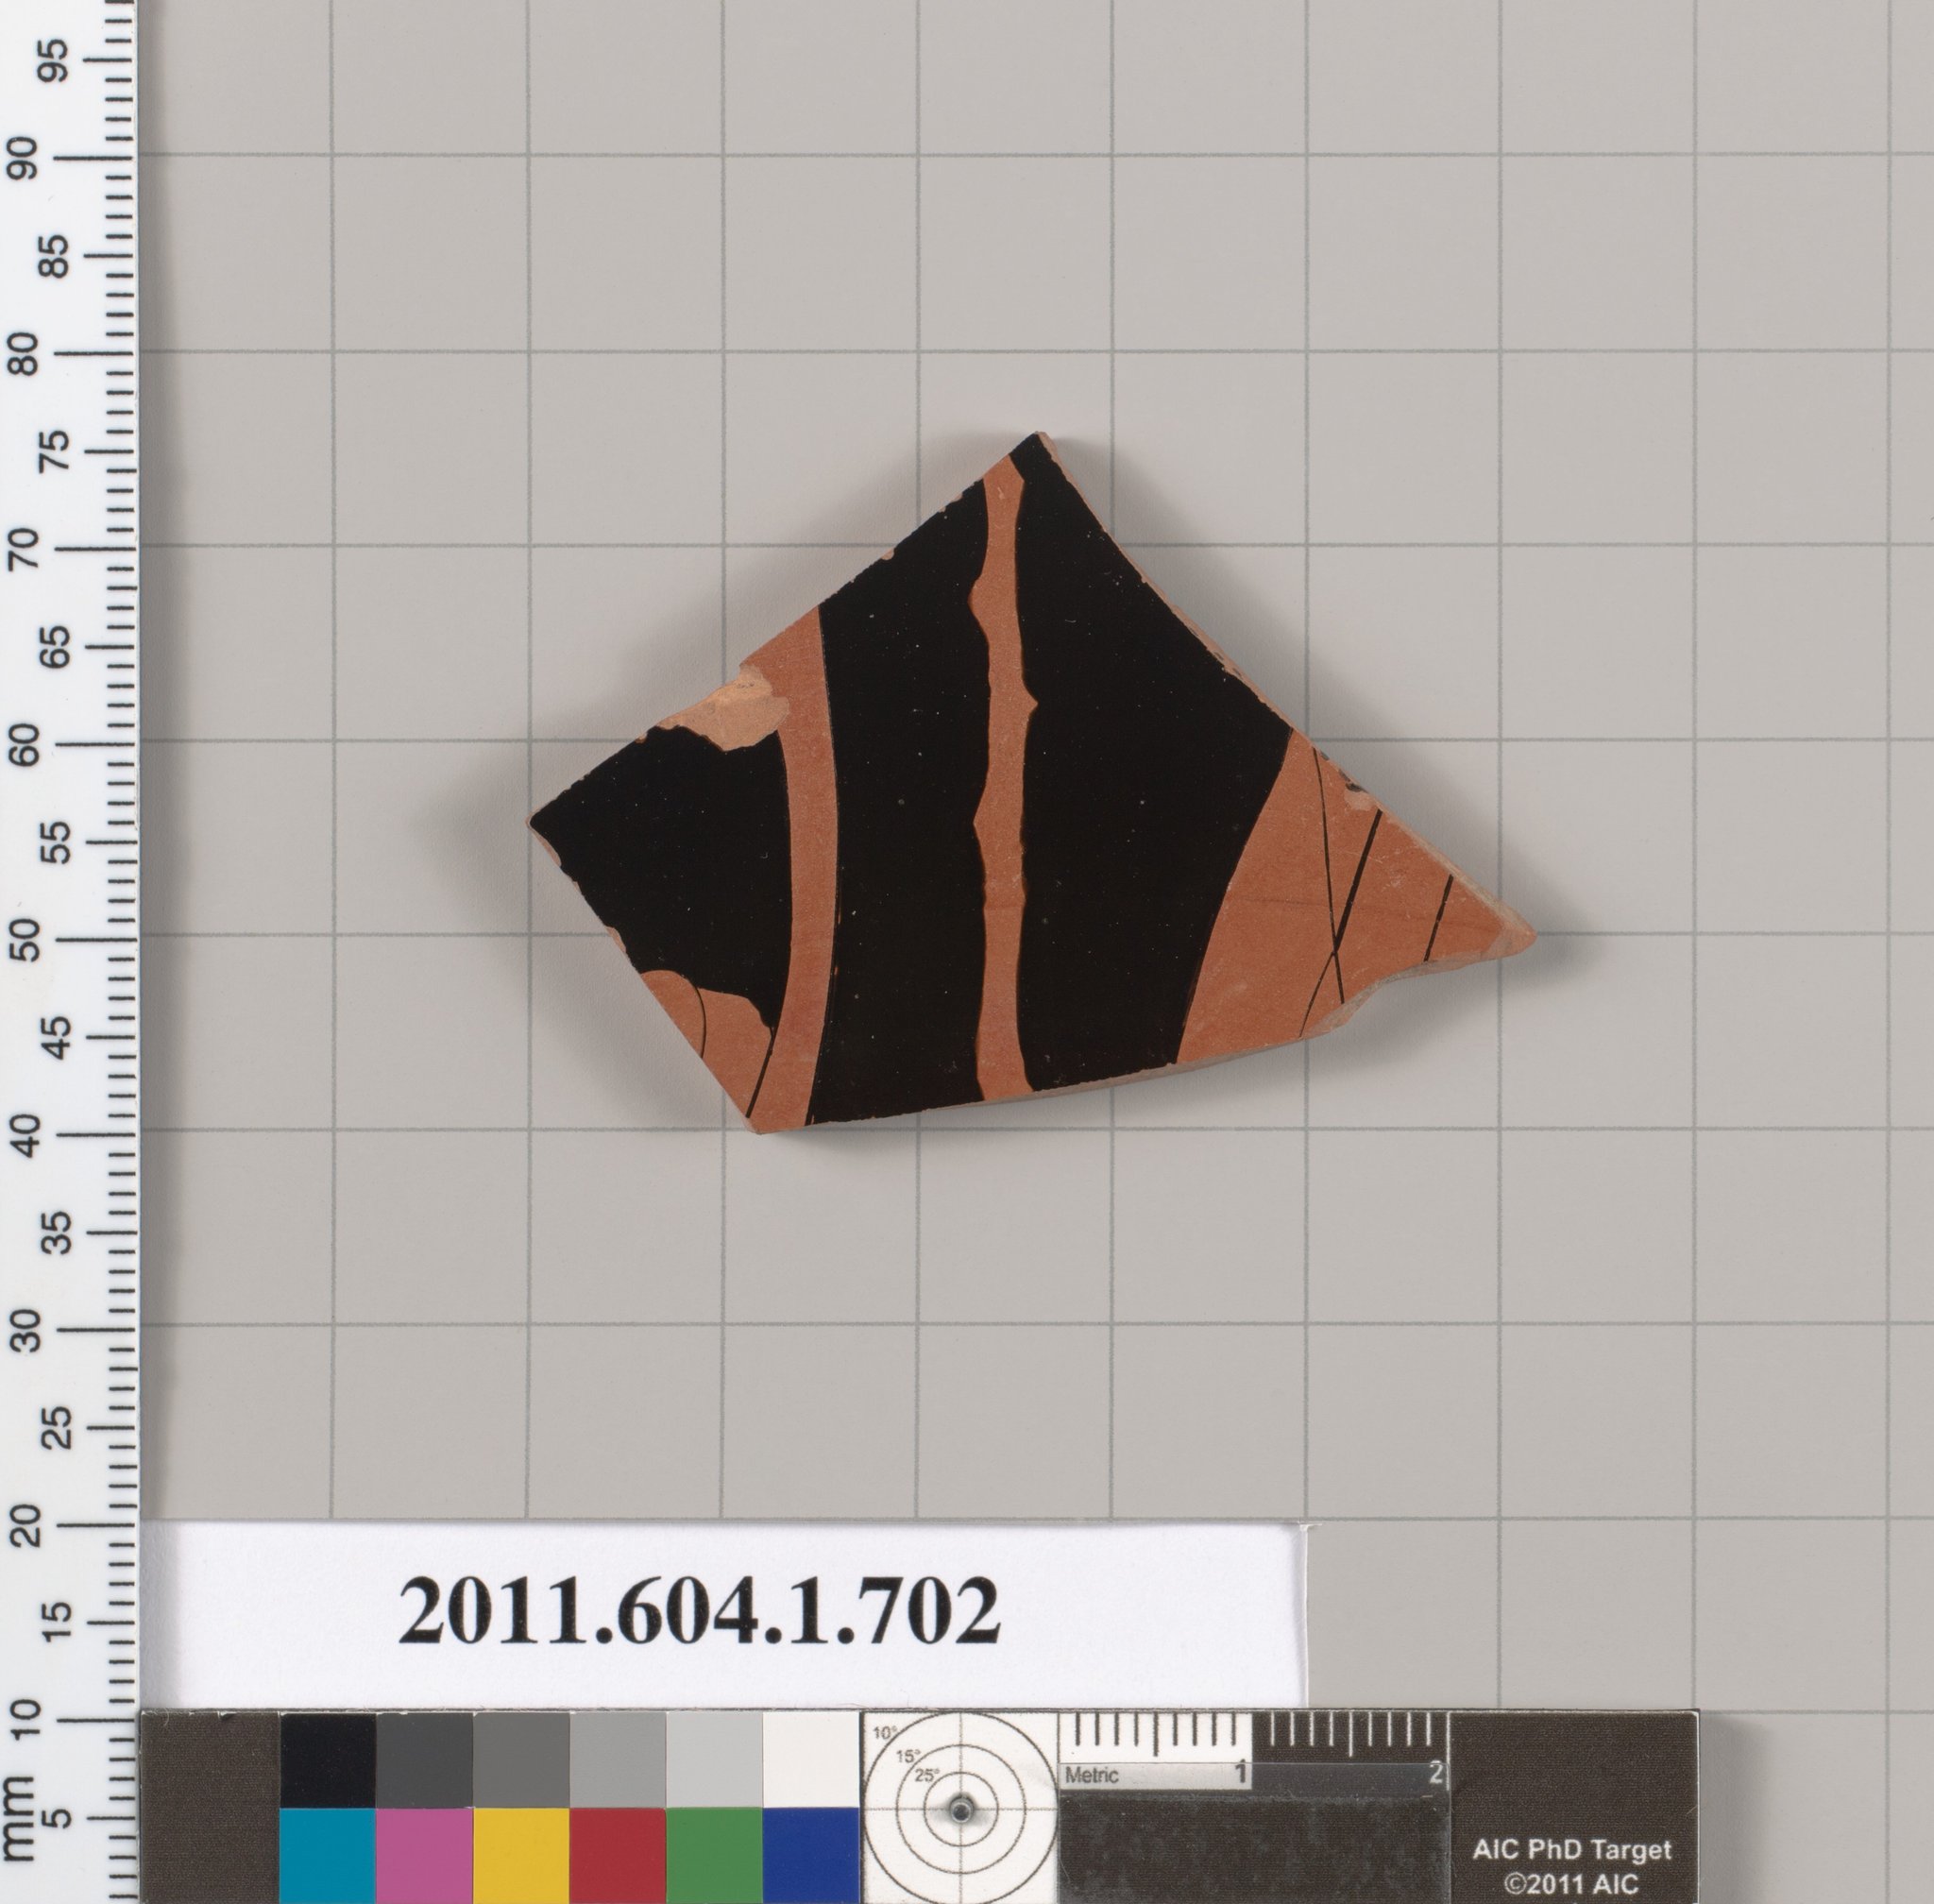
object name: kylix fragment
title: Terracotta fragment of a kylix (drinking cup)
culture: greek, attic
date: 475-451 BCE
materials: terracotta